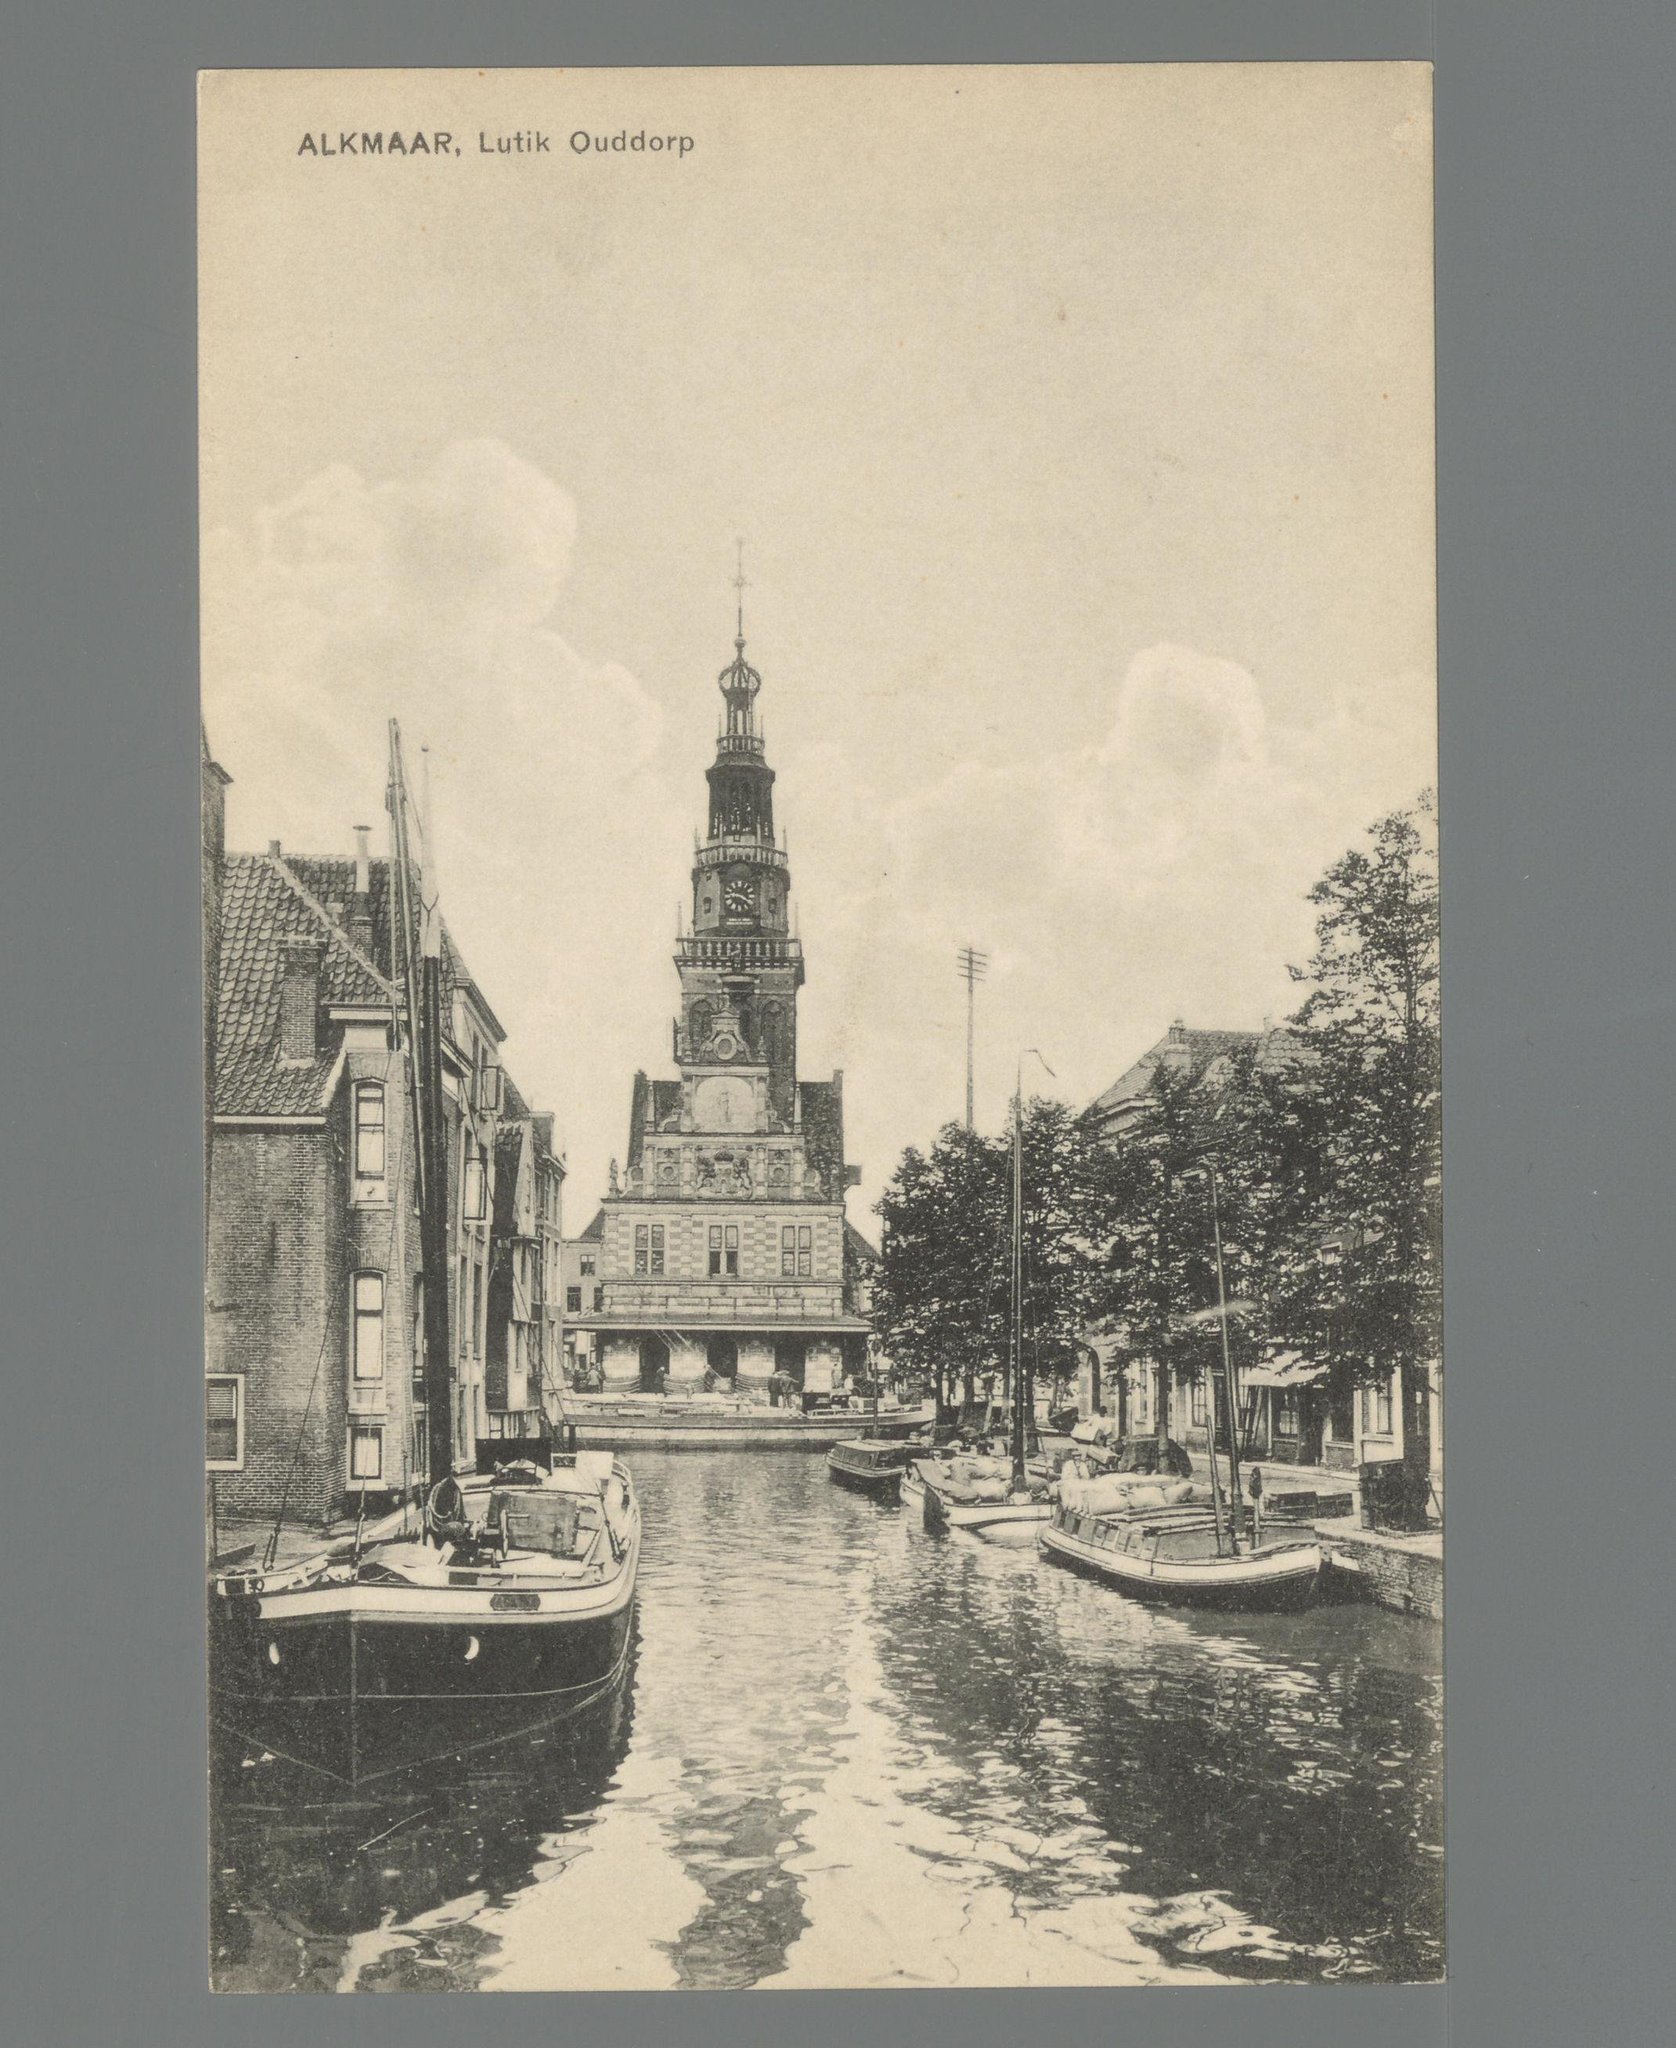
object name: photomechanical print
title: Alkmaar, Lutik Ouddorp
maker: Anonymous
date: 1906-1930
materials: cardboard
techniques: photograph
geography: alkmaar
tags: city-view, and landscape with man-made constructions, sailing-ship, sailing-boat, tower, clock tower ~ monumental adornment, canals, waters (in city)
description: Mogelijk gedateerd 1919 op verso, eerste twee cijfers van het getal.